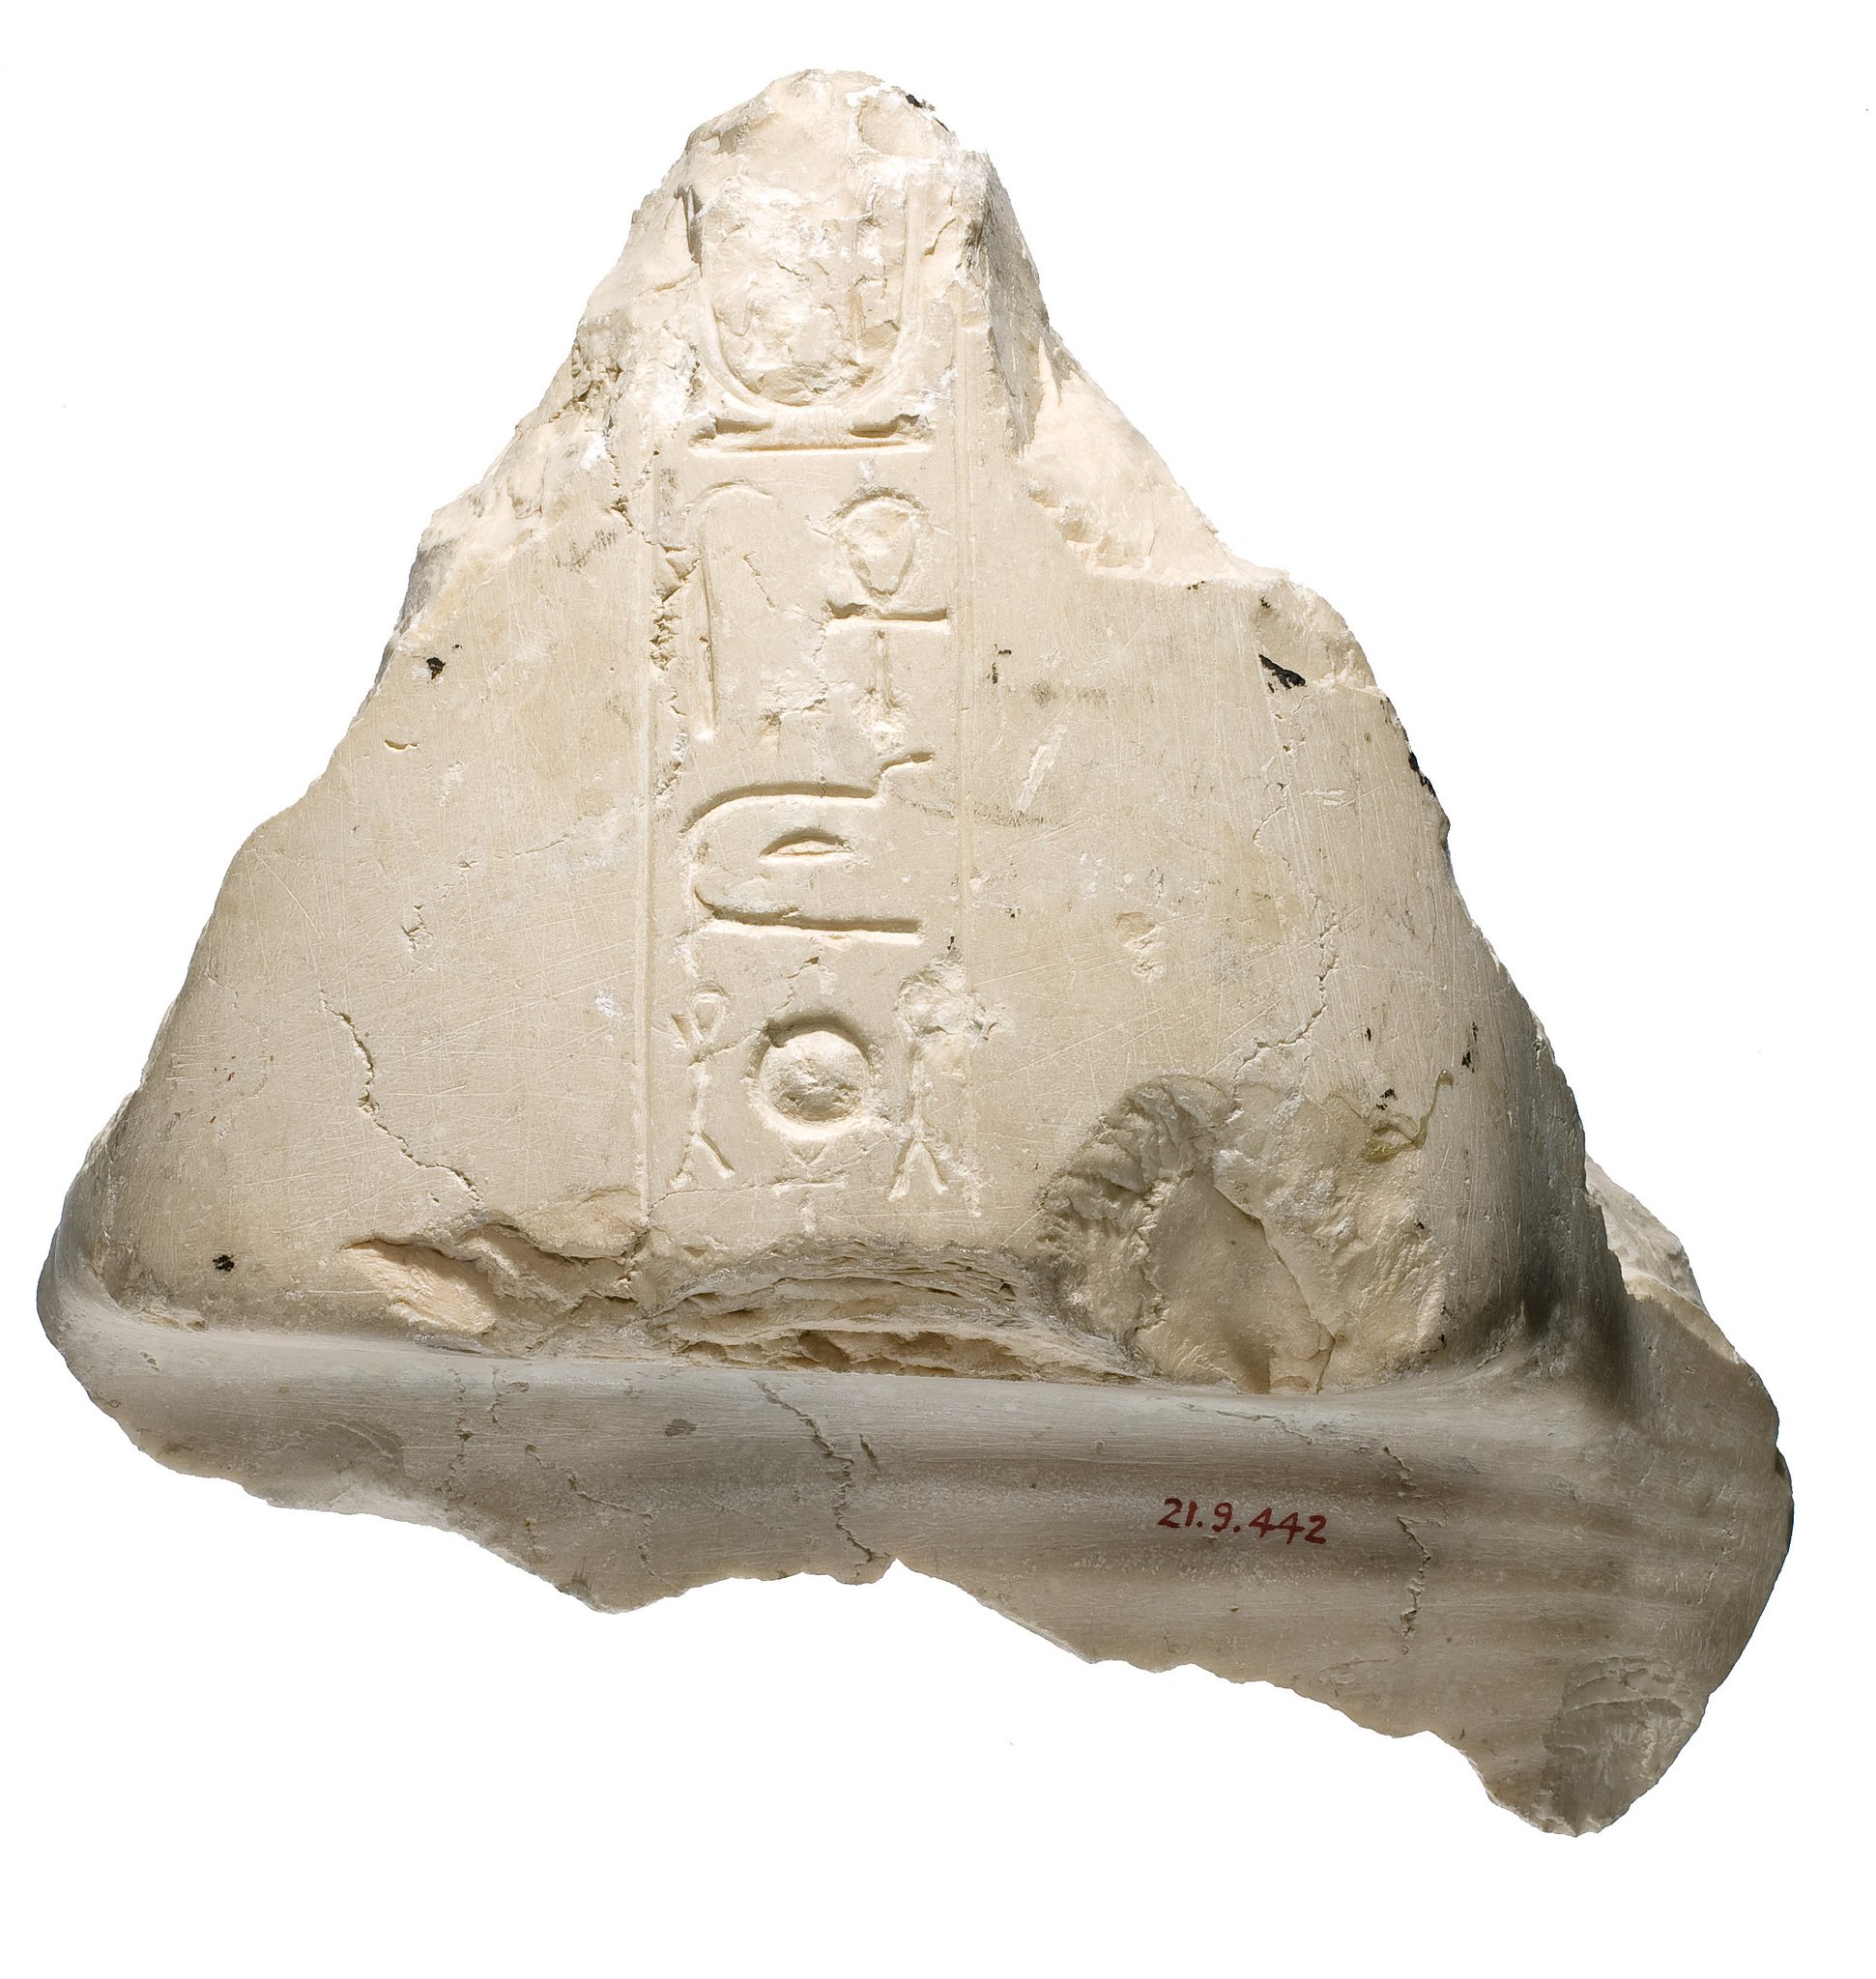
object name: nefertiti head wig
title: Wig of Nefertiti, inscribed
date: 1352-1336 BCE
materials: limestone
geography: egypt